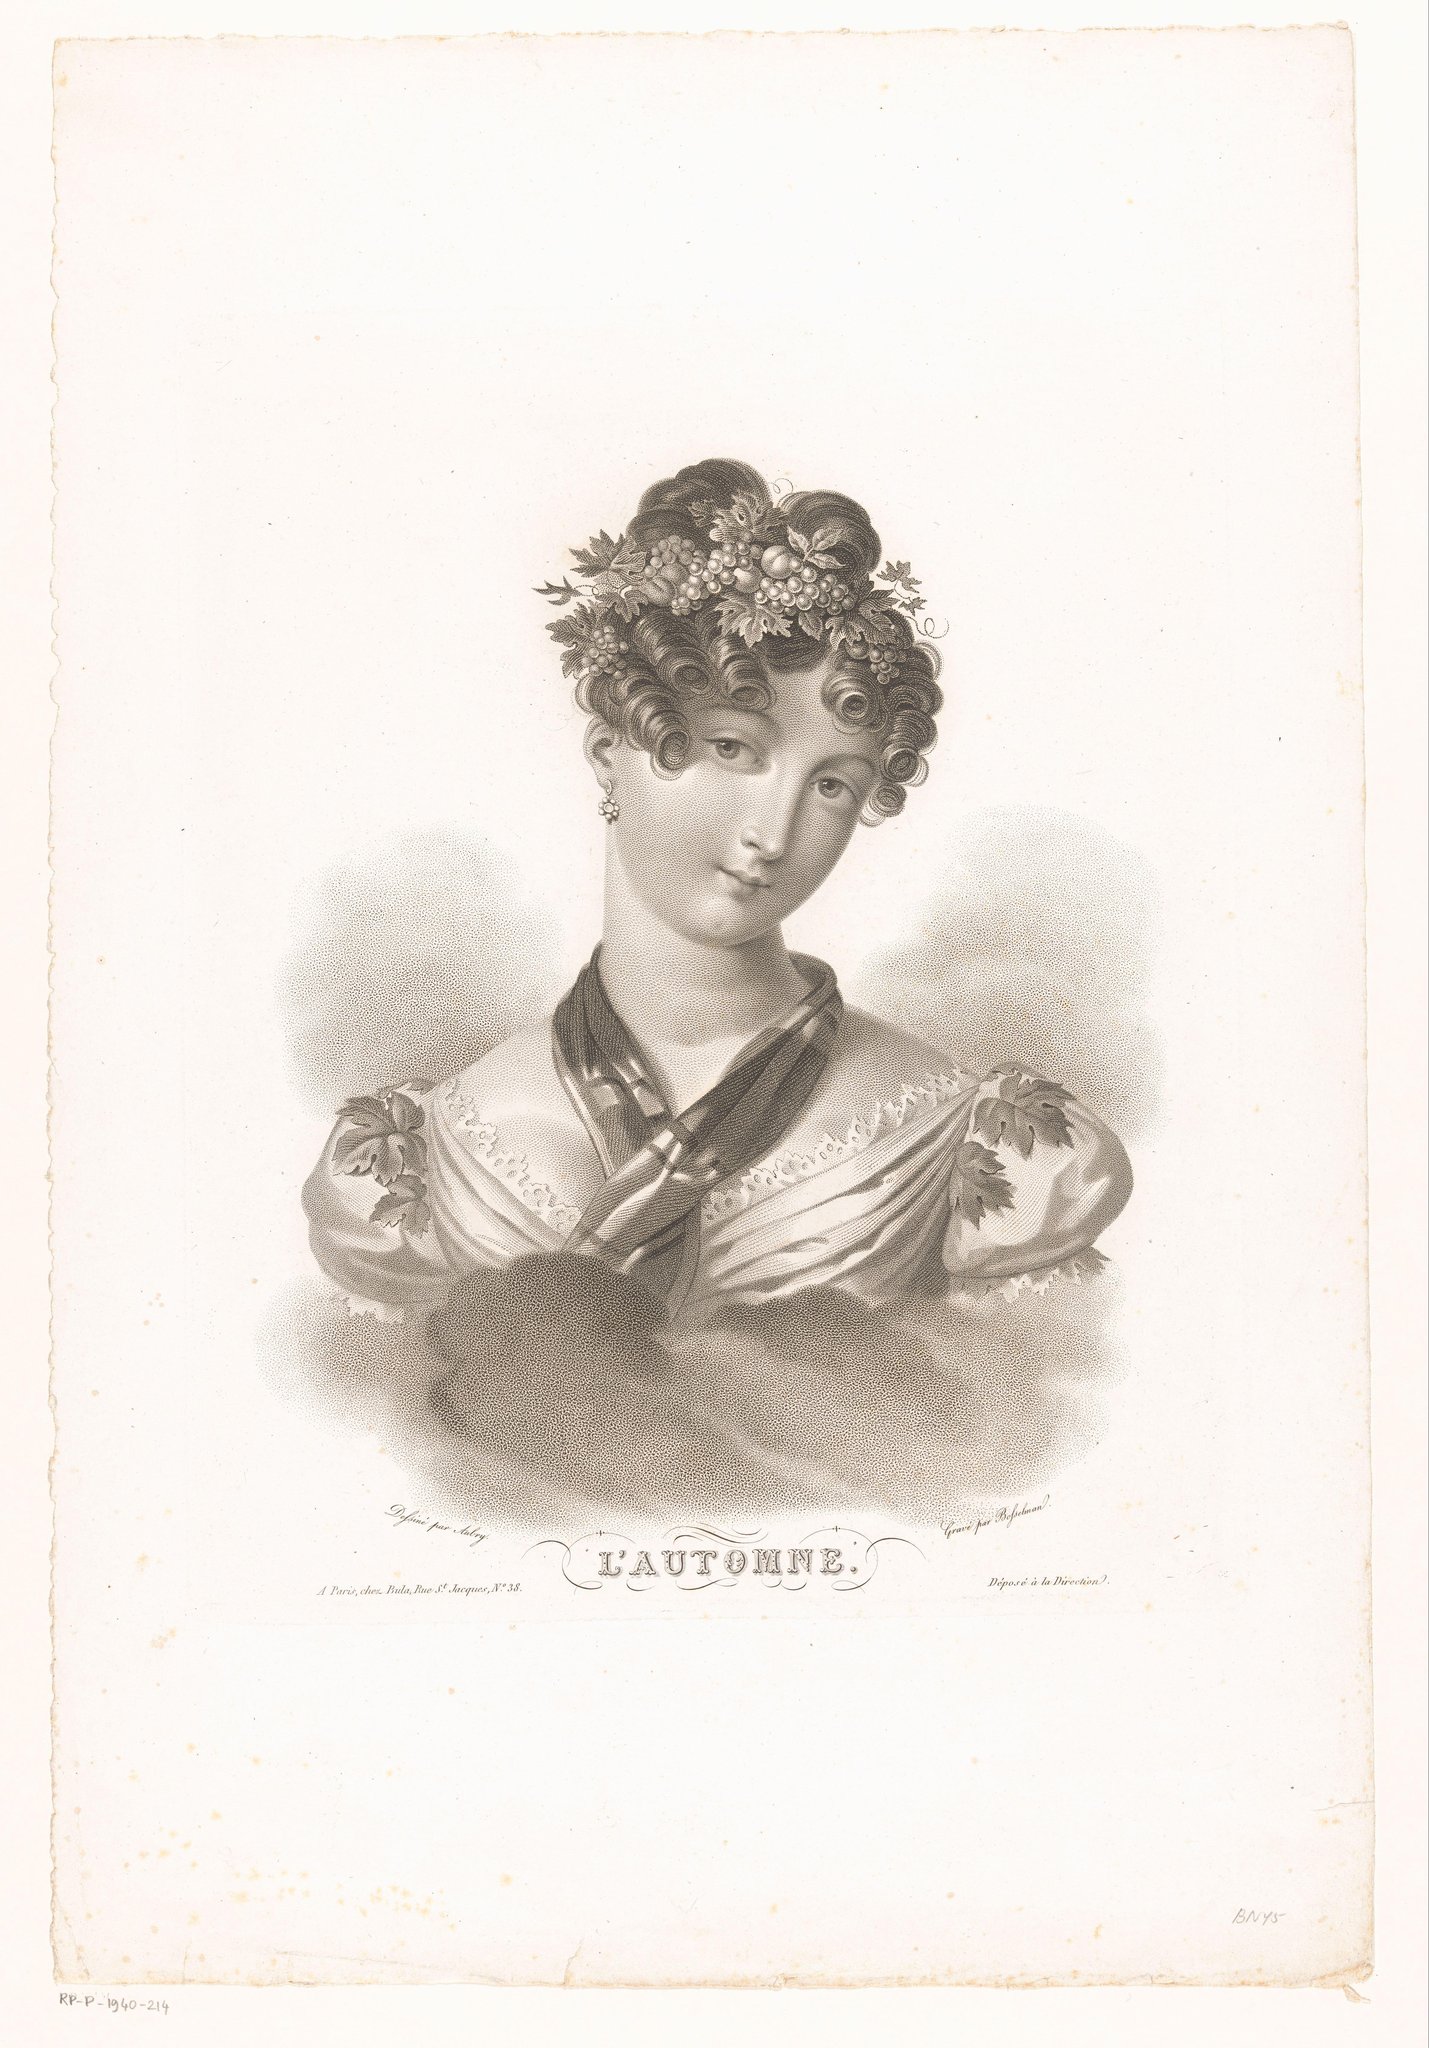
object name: print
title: L'Automne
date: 1824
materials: paper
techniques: engraving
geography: paris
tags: year divided into four seasons, autumn, fall, 'autumnus'; 'autunno' (ripa)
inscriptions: : ‘Déposé à la Direction.’, collector's mark: Lugt 2228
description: Maakt deel uit van een serie van vier prenten voorstellende de vier seizoenen in de vorm van vier vrouwen in seizoensgebonden kostuums.